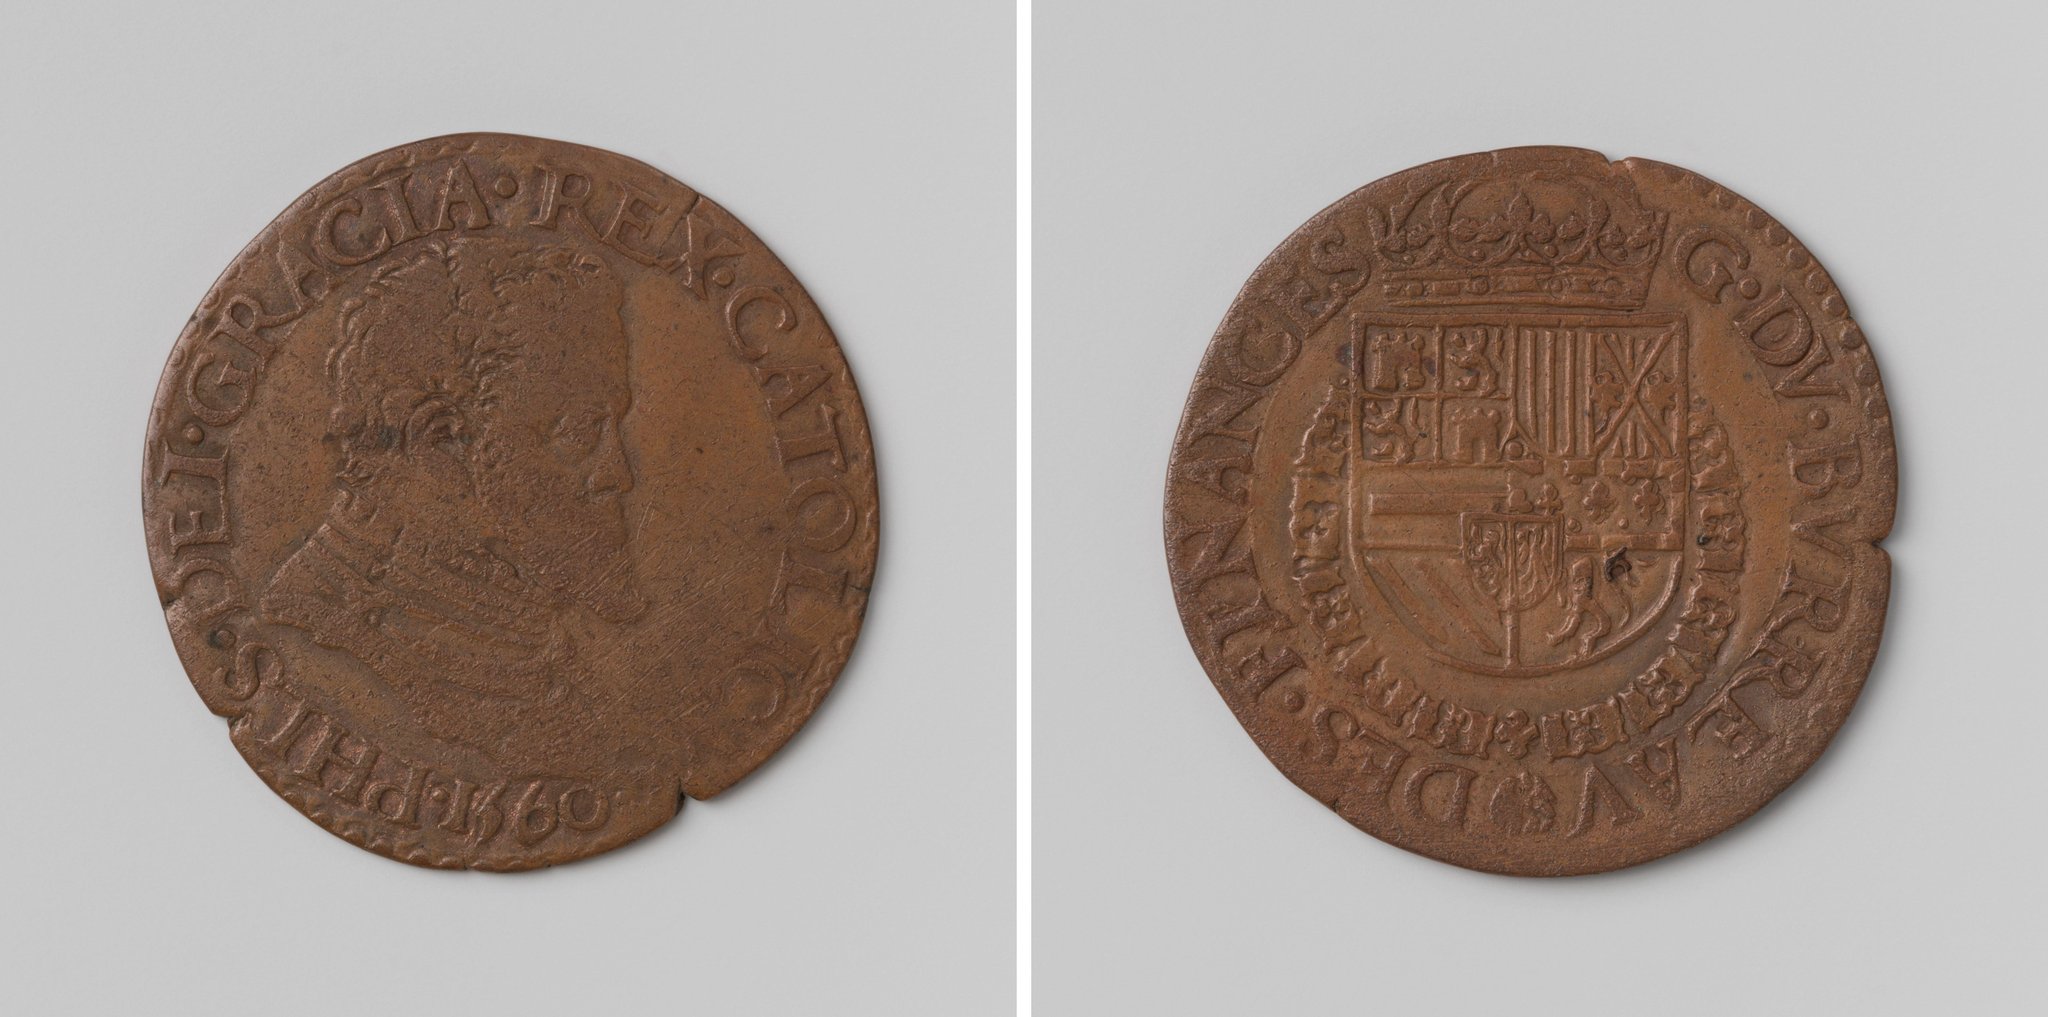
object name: jeton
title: Filips II, koning van Spanje, rekenpenning van de raad van Financiën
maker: Anonymous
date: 1560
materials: copper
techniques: striking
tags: philip ii of spain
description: Koperen penning. Voorzijde: borststuk man binnen omschrift. Keerzijde: gekroond wapenschild omhangen met orde van Gulden Vlies binnen omschrift